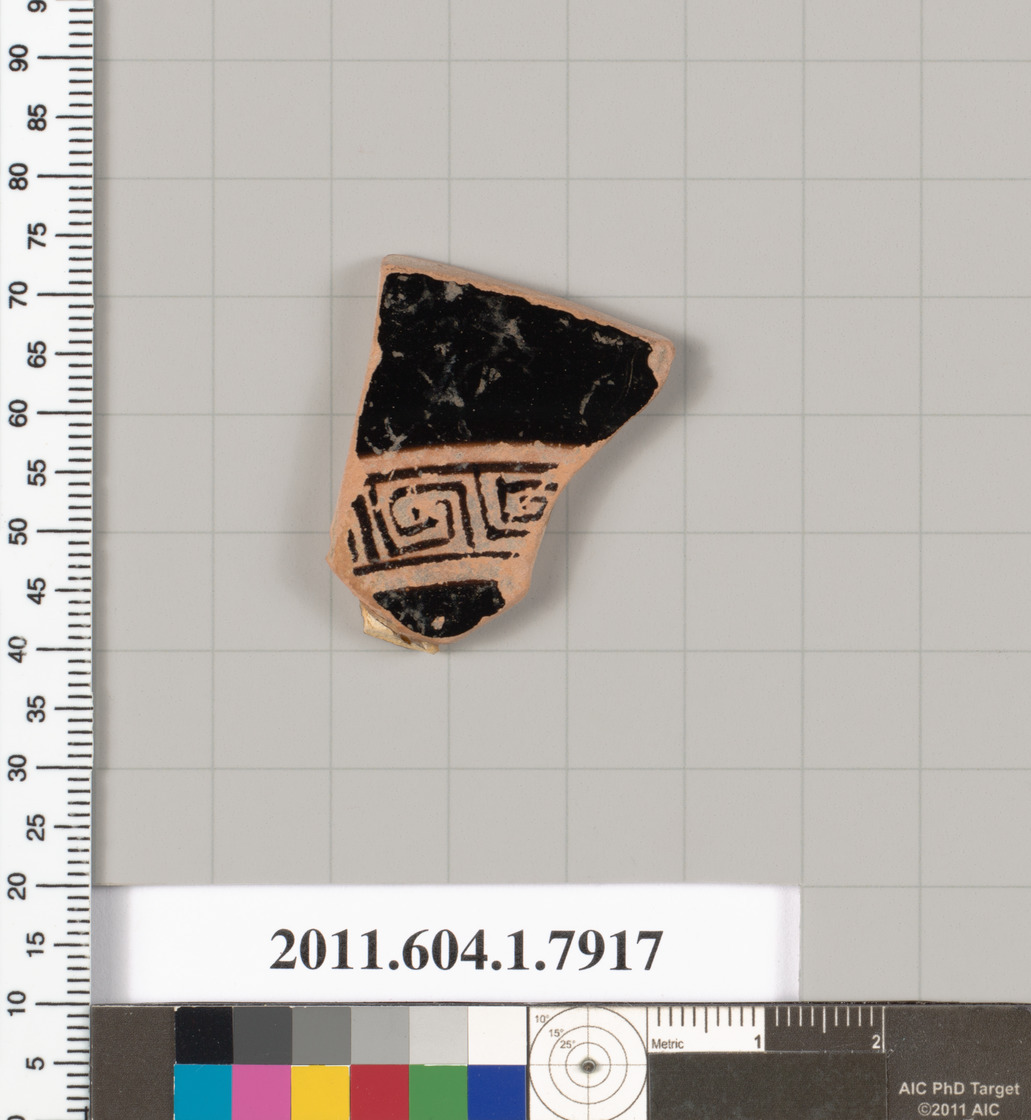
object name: kylix fragment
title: Terracotta fragment of a kylix (drinking cup)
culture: greek, attic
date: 460-450 BCE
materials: terracotta